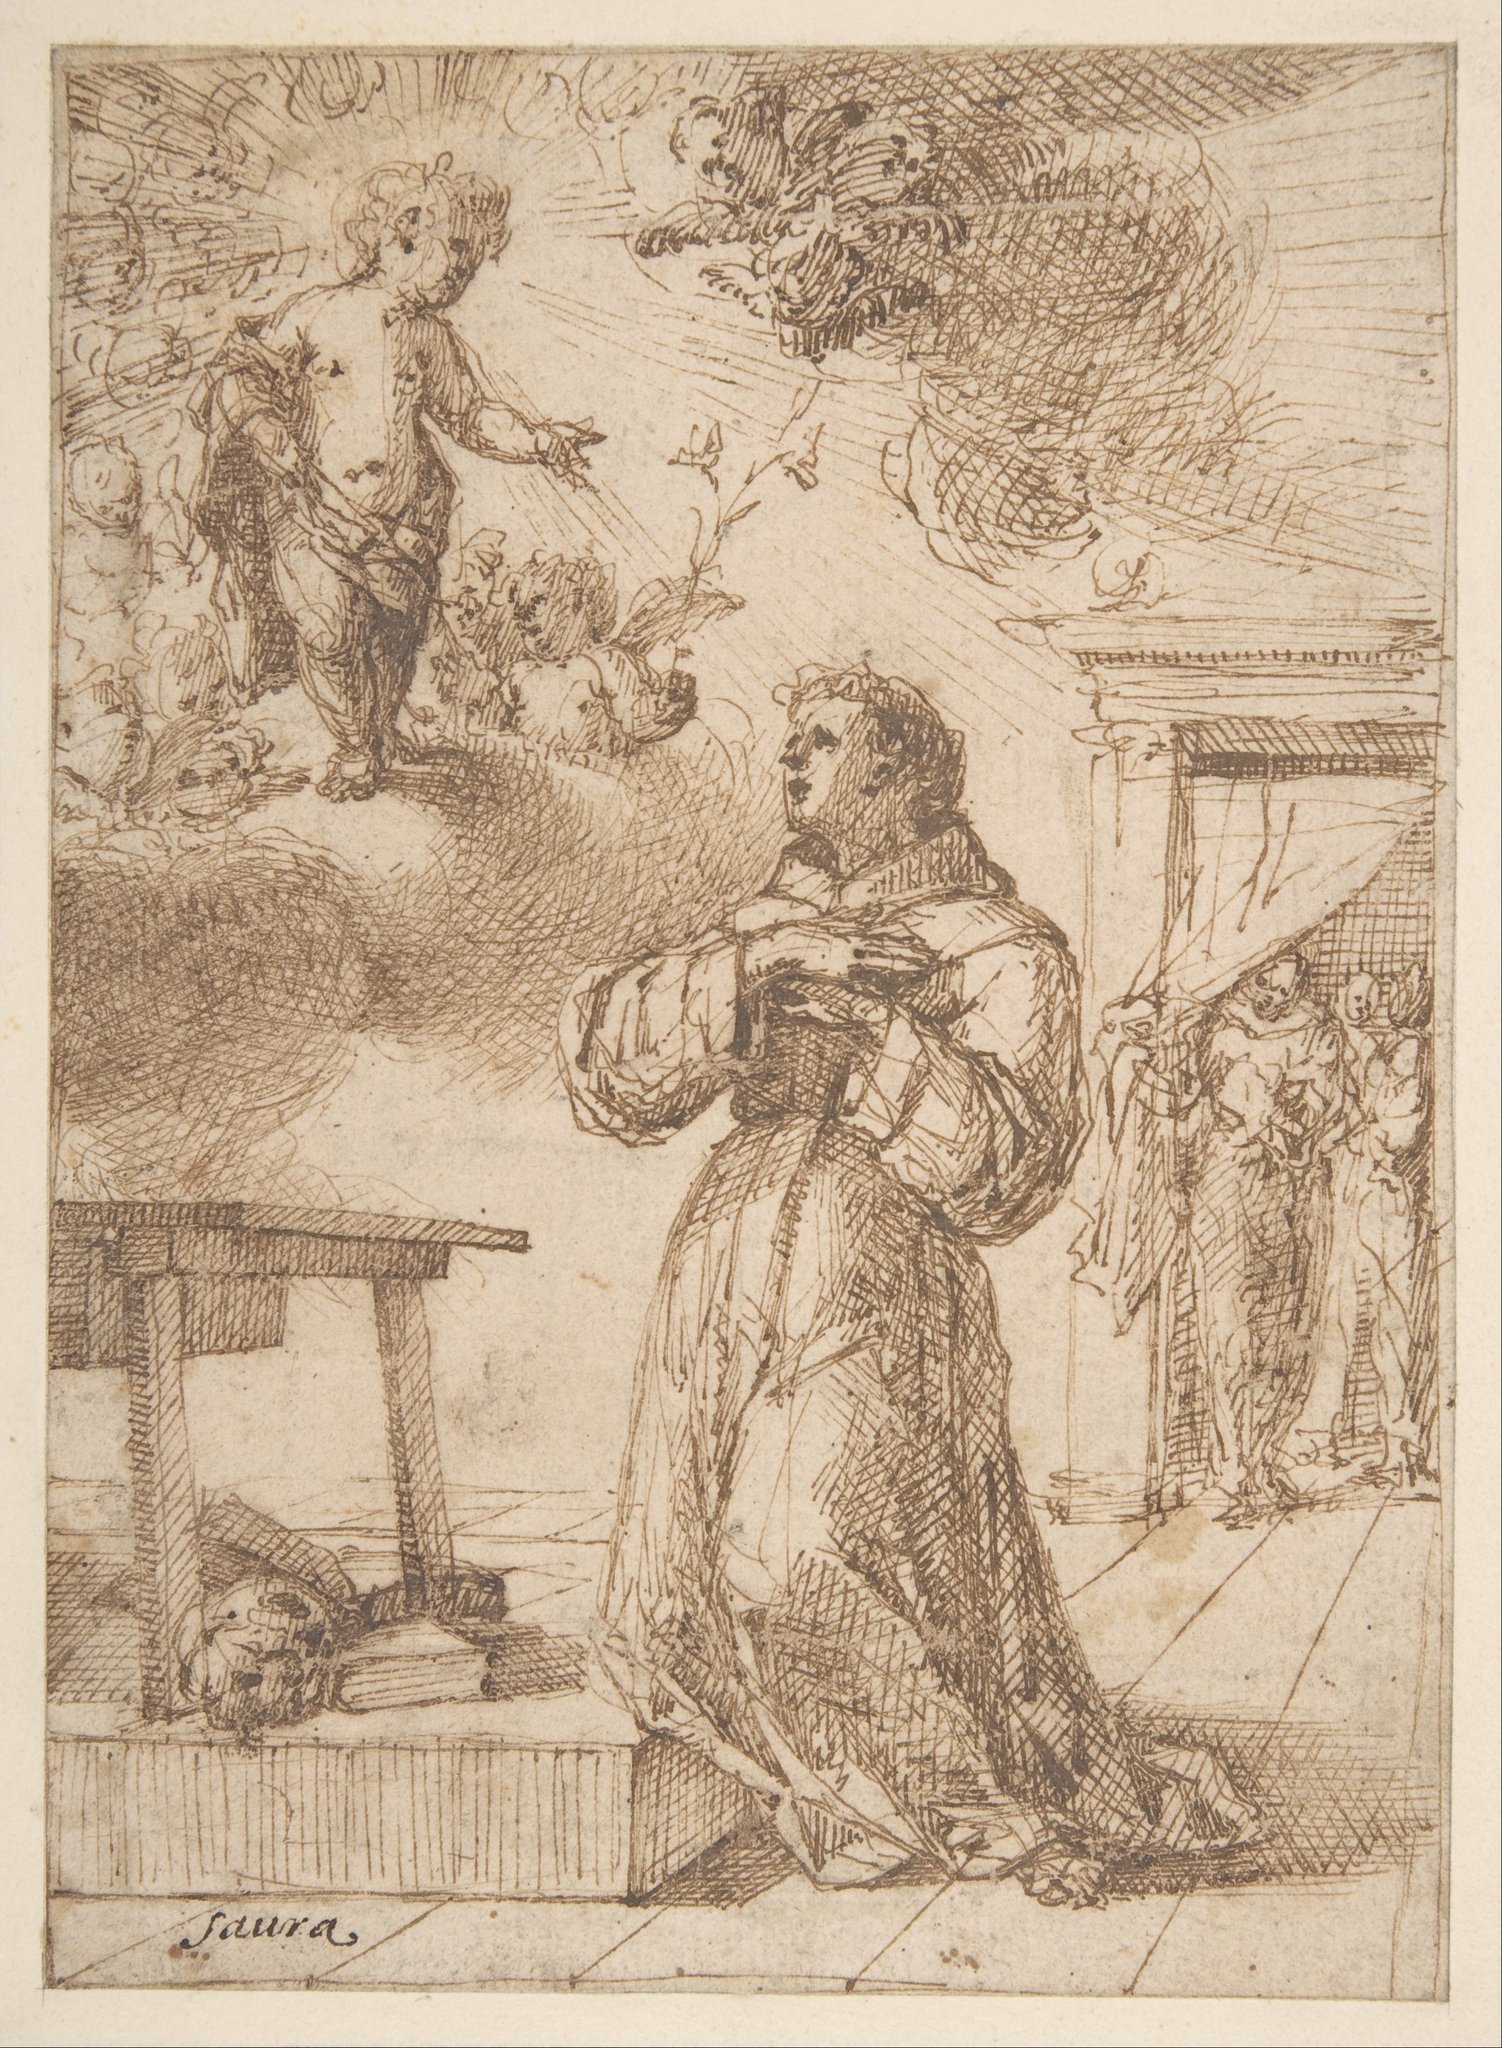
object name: drawing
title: The Vision of Saint Anthony of Padua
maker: vicente salvador gómez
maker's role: artist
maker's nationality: spanish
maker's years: 1637-1700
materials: ink, drawing material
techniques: pen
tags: men,mythical creatures,saint anthony